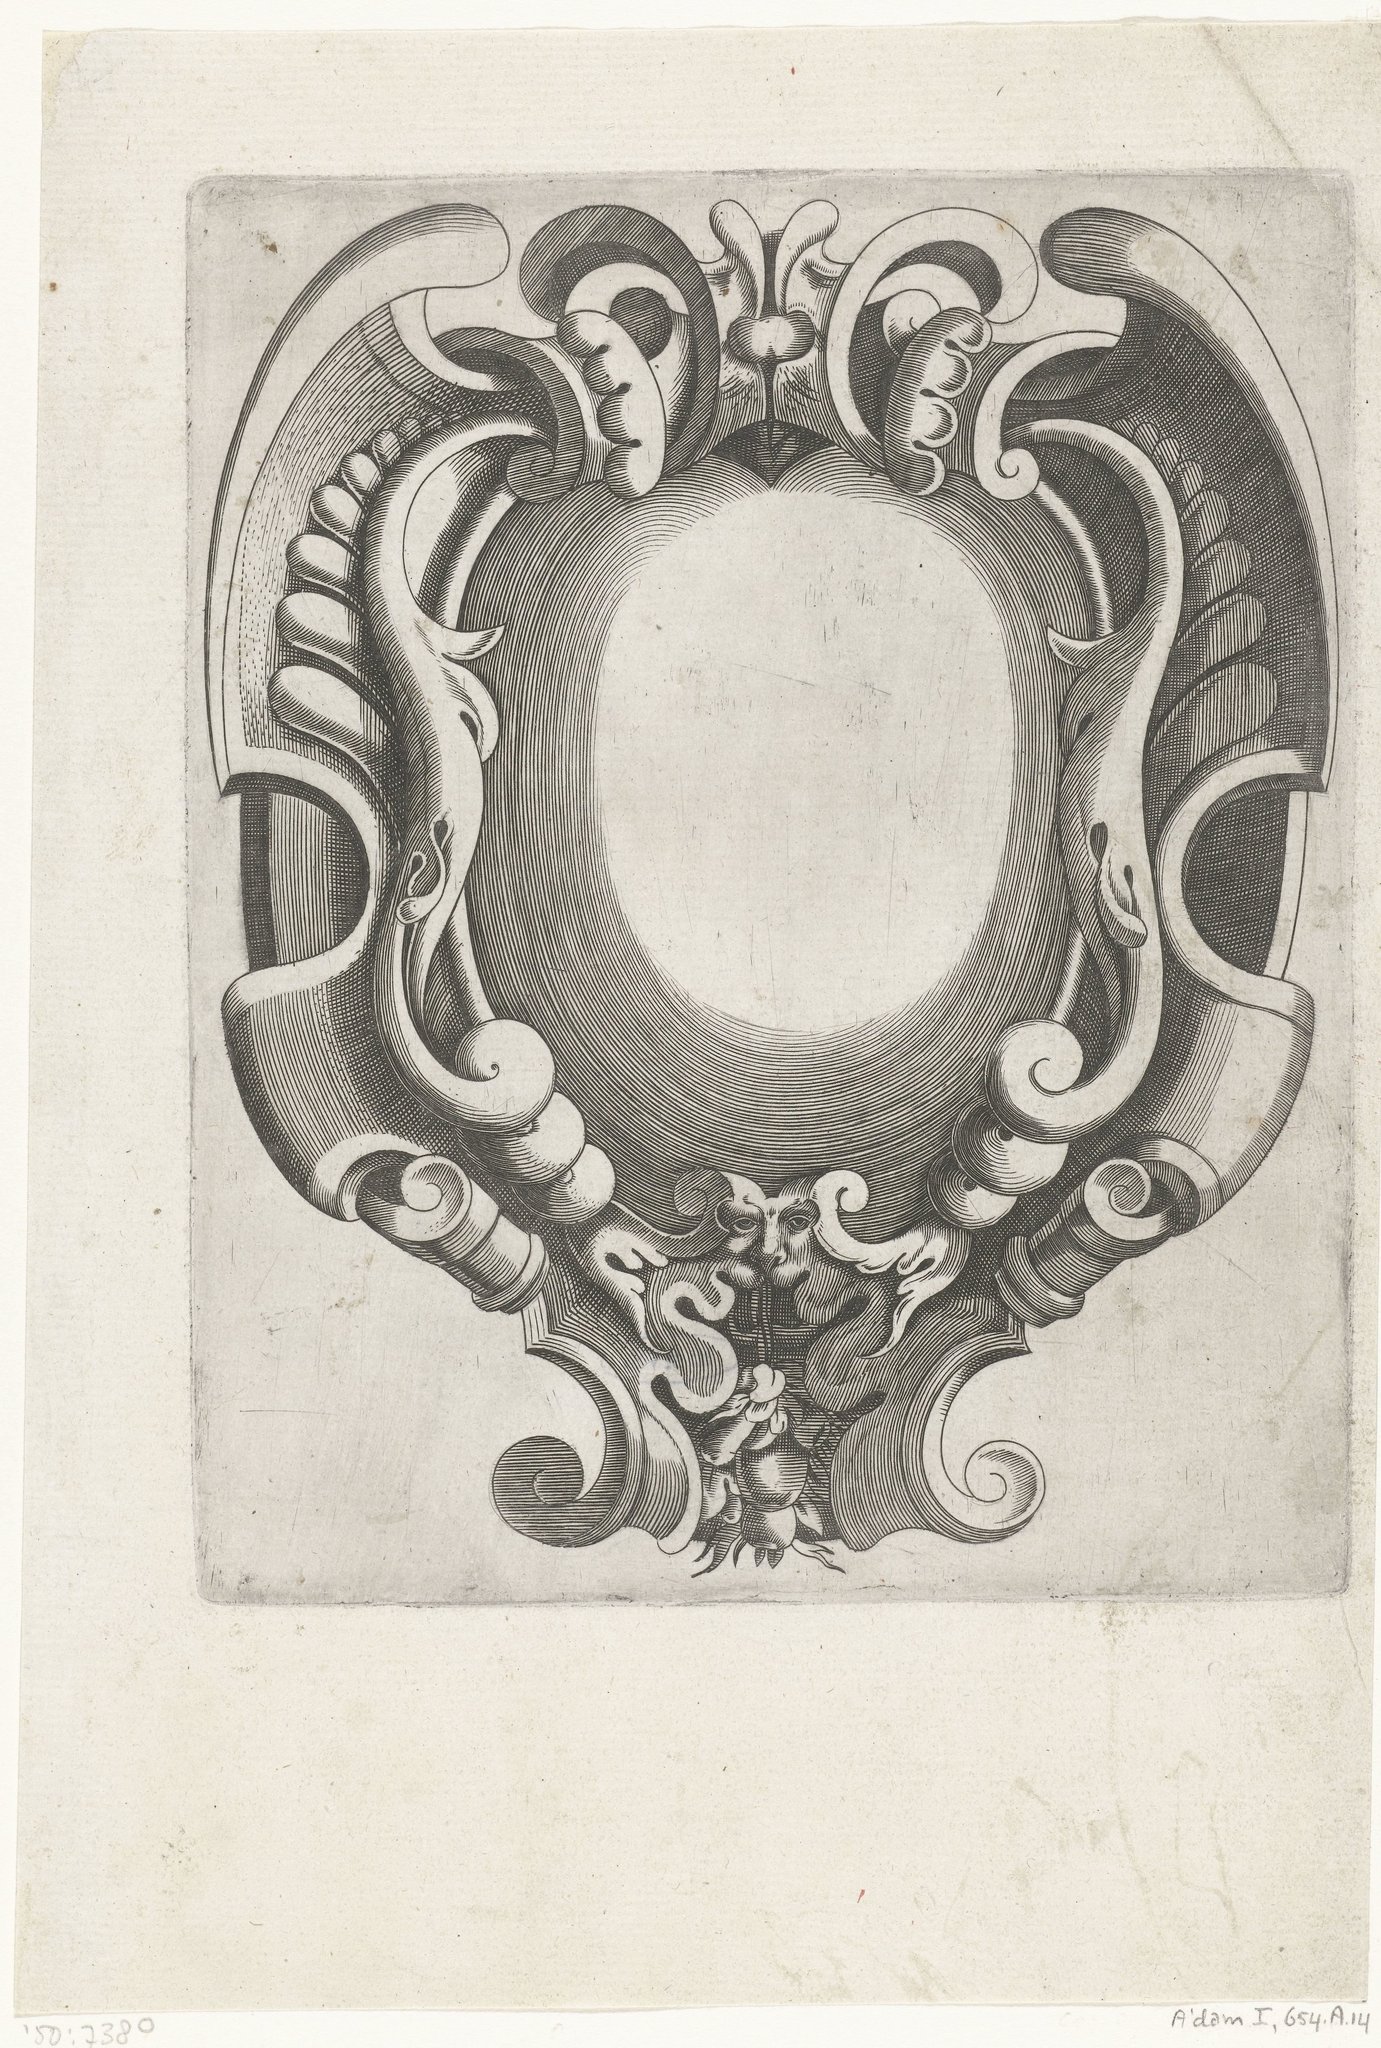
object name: print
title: Cartouche met mascaron dat trosje vruchten in de mond heeft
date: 1628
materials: paper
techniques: engraving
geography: france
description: Tegenzijdige kopie naar blad 16 uit serie met cartouches in omlijstingen van rolwerk met grotesken, guirlandes en mascarons uitgegeven door Pierre Mariette.